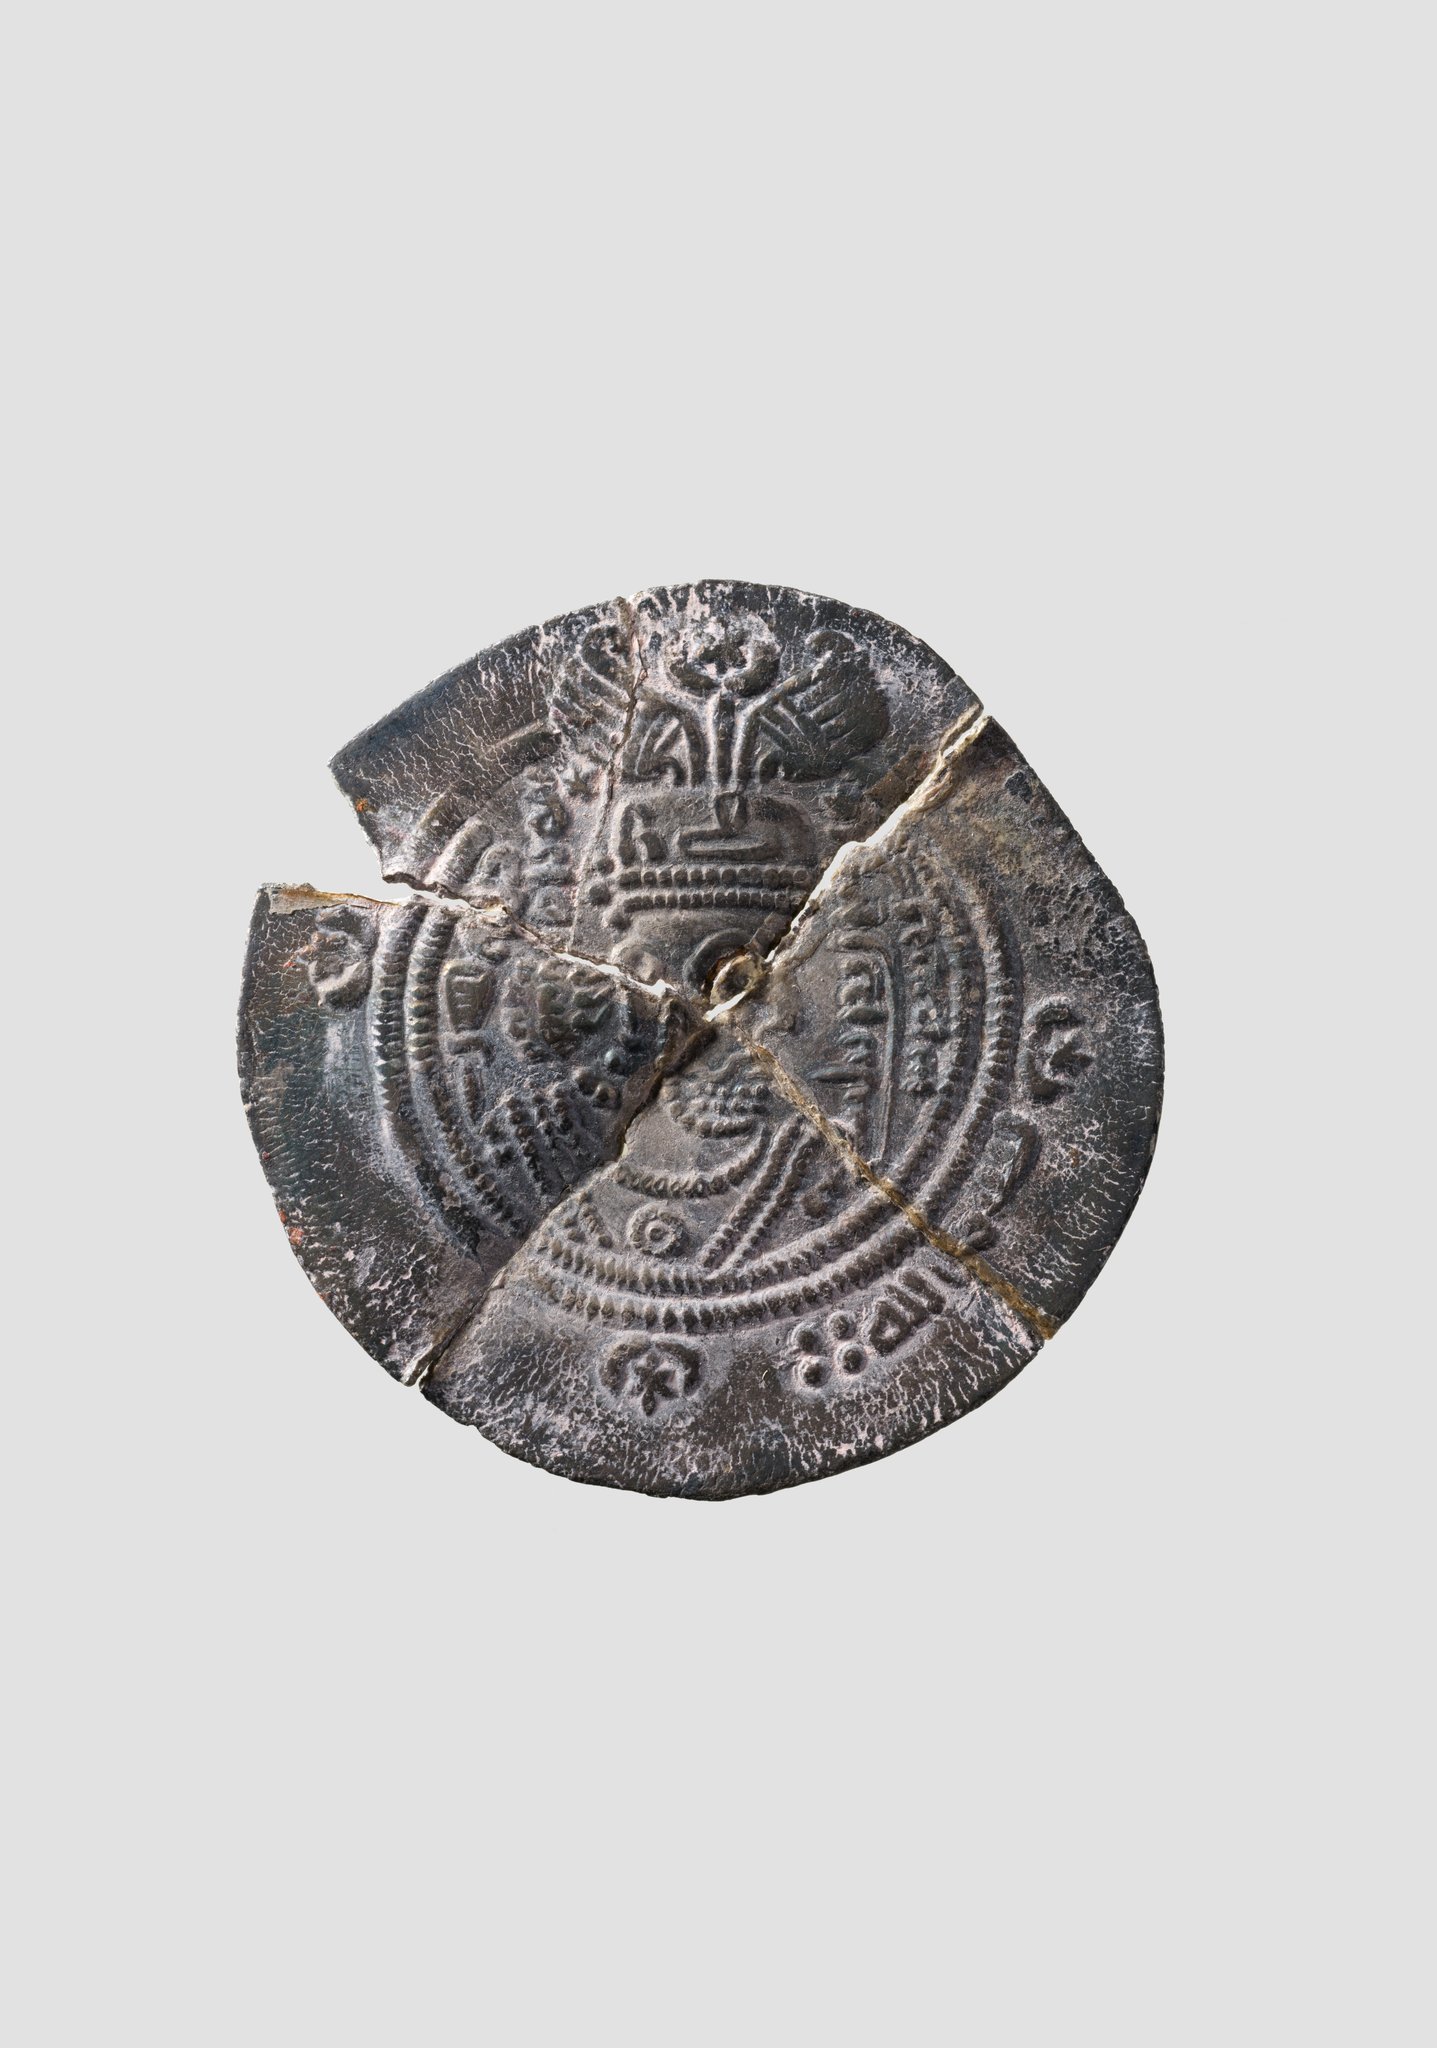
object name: coin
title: Dirhem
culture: islamic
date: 58-677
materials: silver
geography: iran